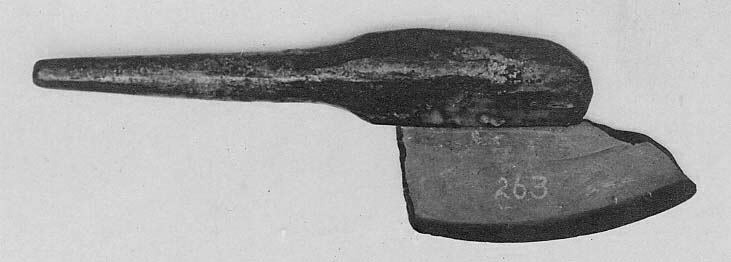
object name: knife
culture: north american, alaskan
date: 1902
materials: jade